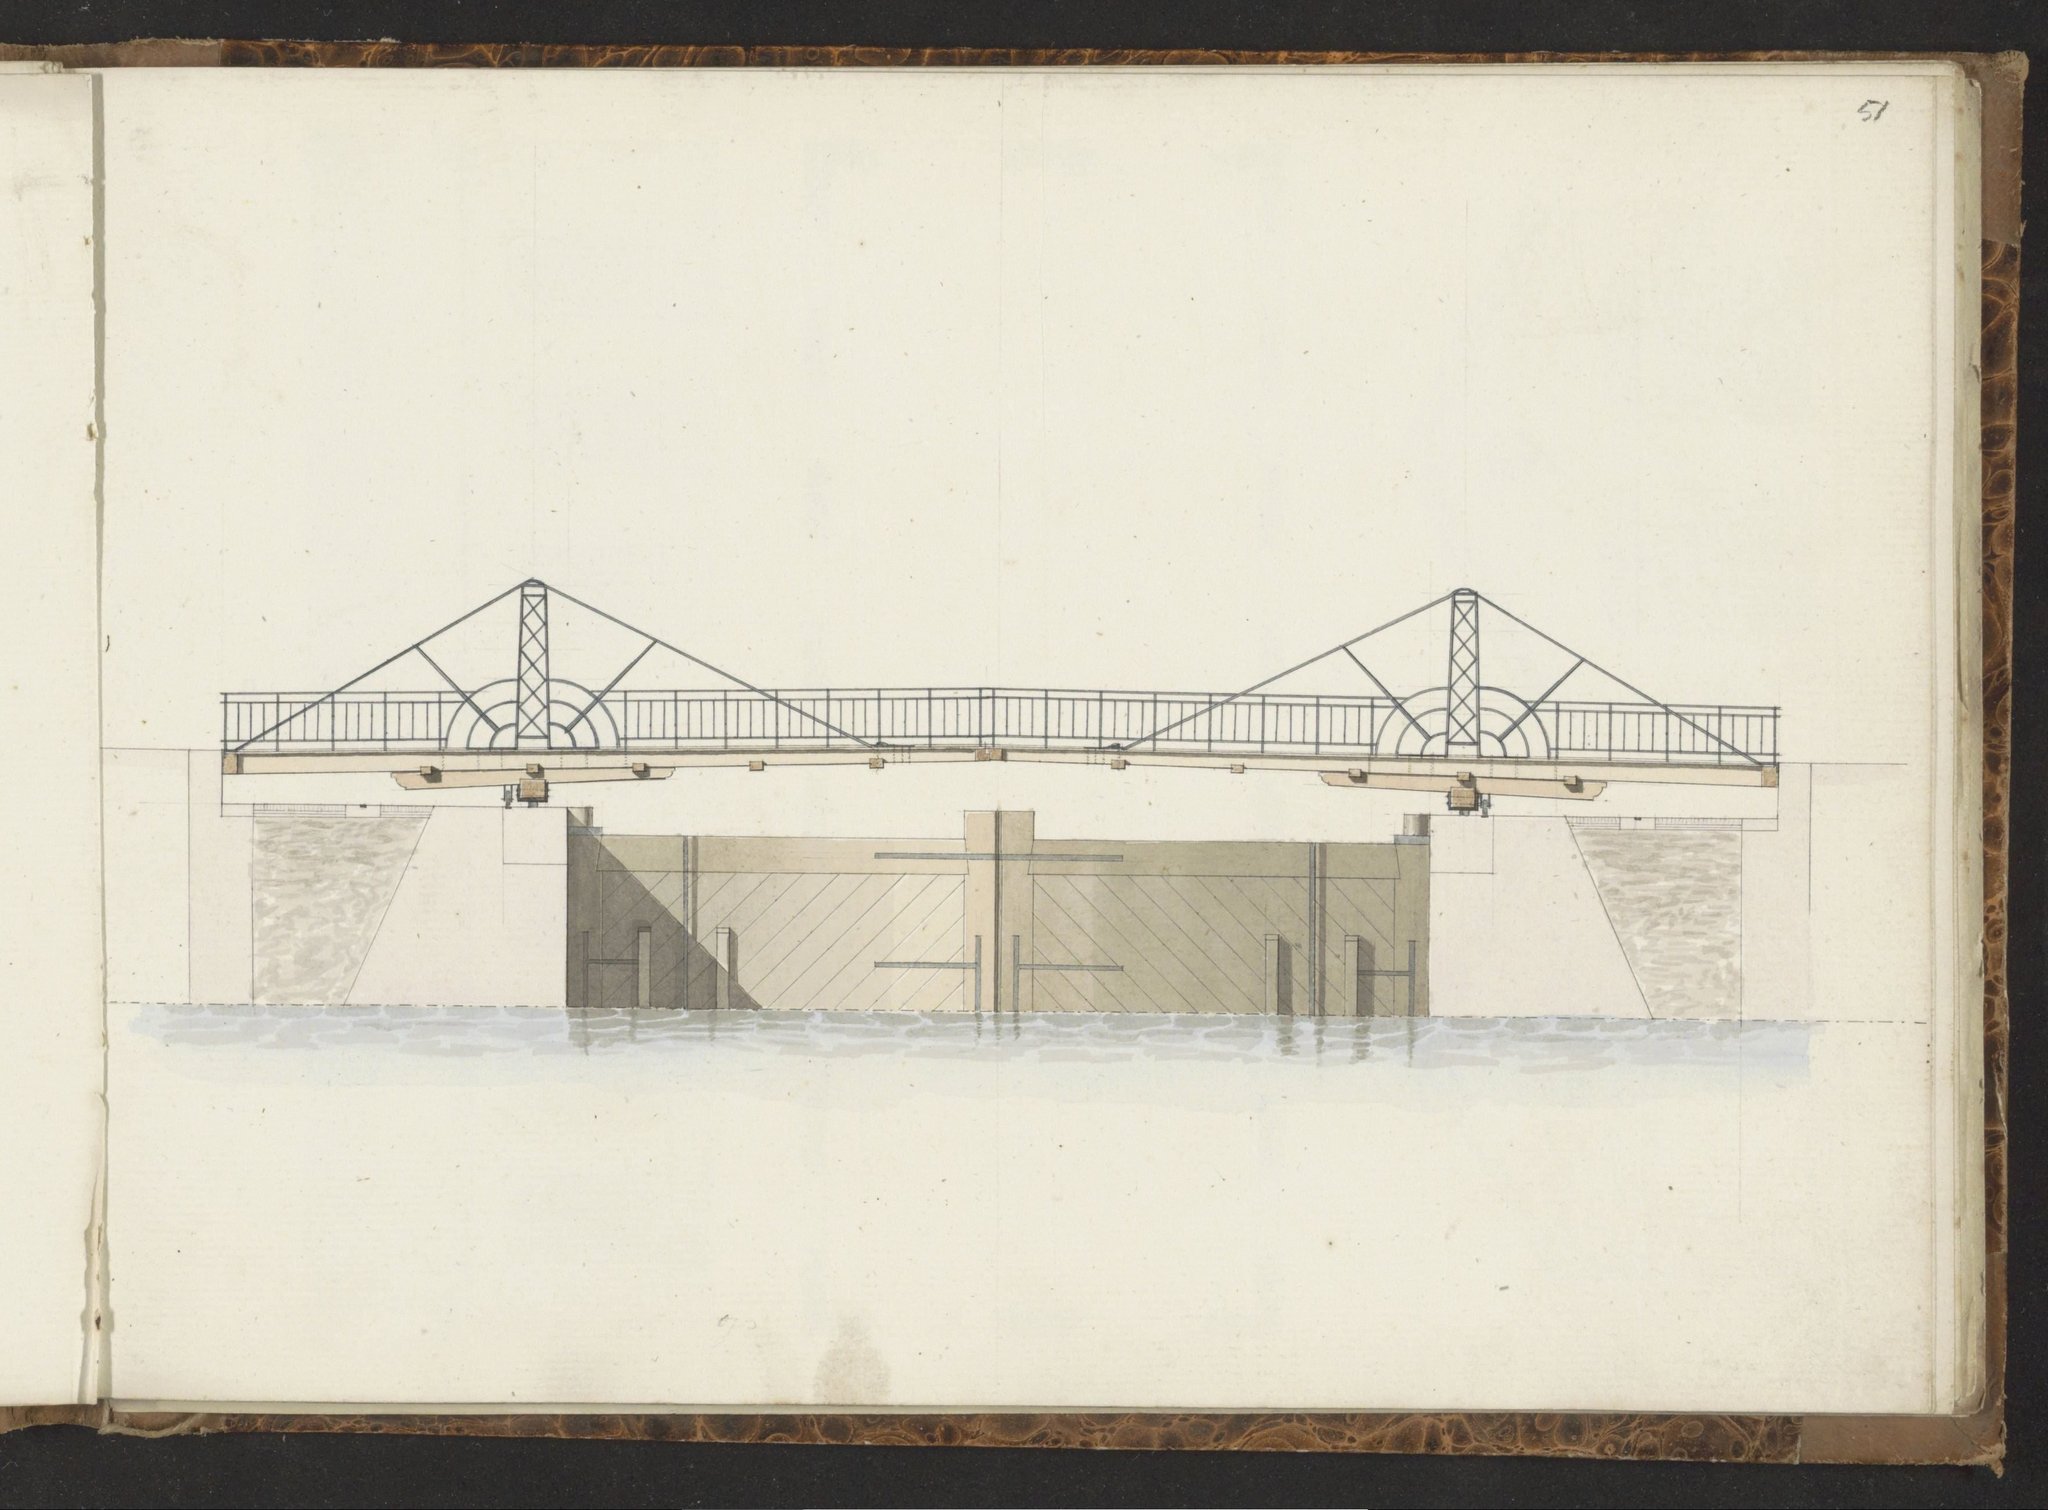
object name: sketchbook leaf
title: Brug over een sluis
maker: willem springer jr.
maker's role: draughtsman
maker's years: 1815-1907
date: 1825-1907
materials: ink, paper, pencil, watercolor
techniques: brush, pen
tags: lift-lock, canal lock, bridge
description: Pagina 51 uit een schetsboek met 86 pagina's.